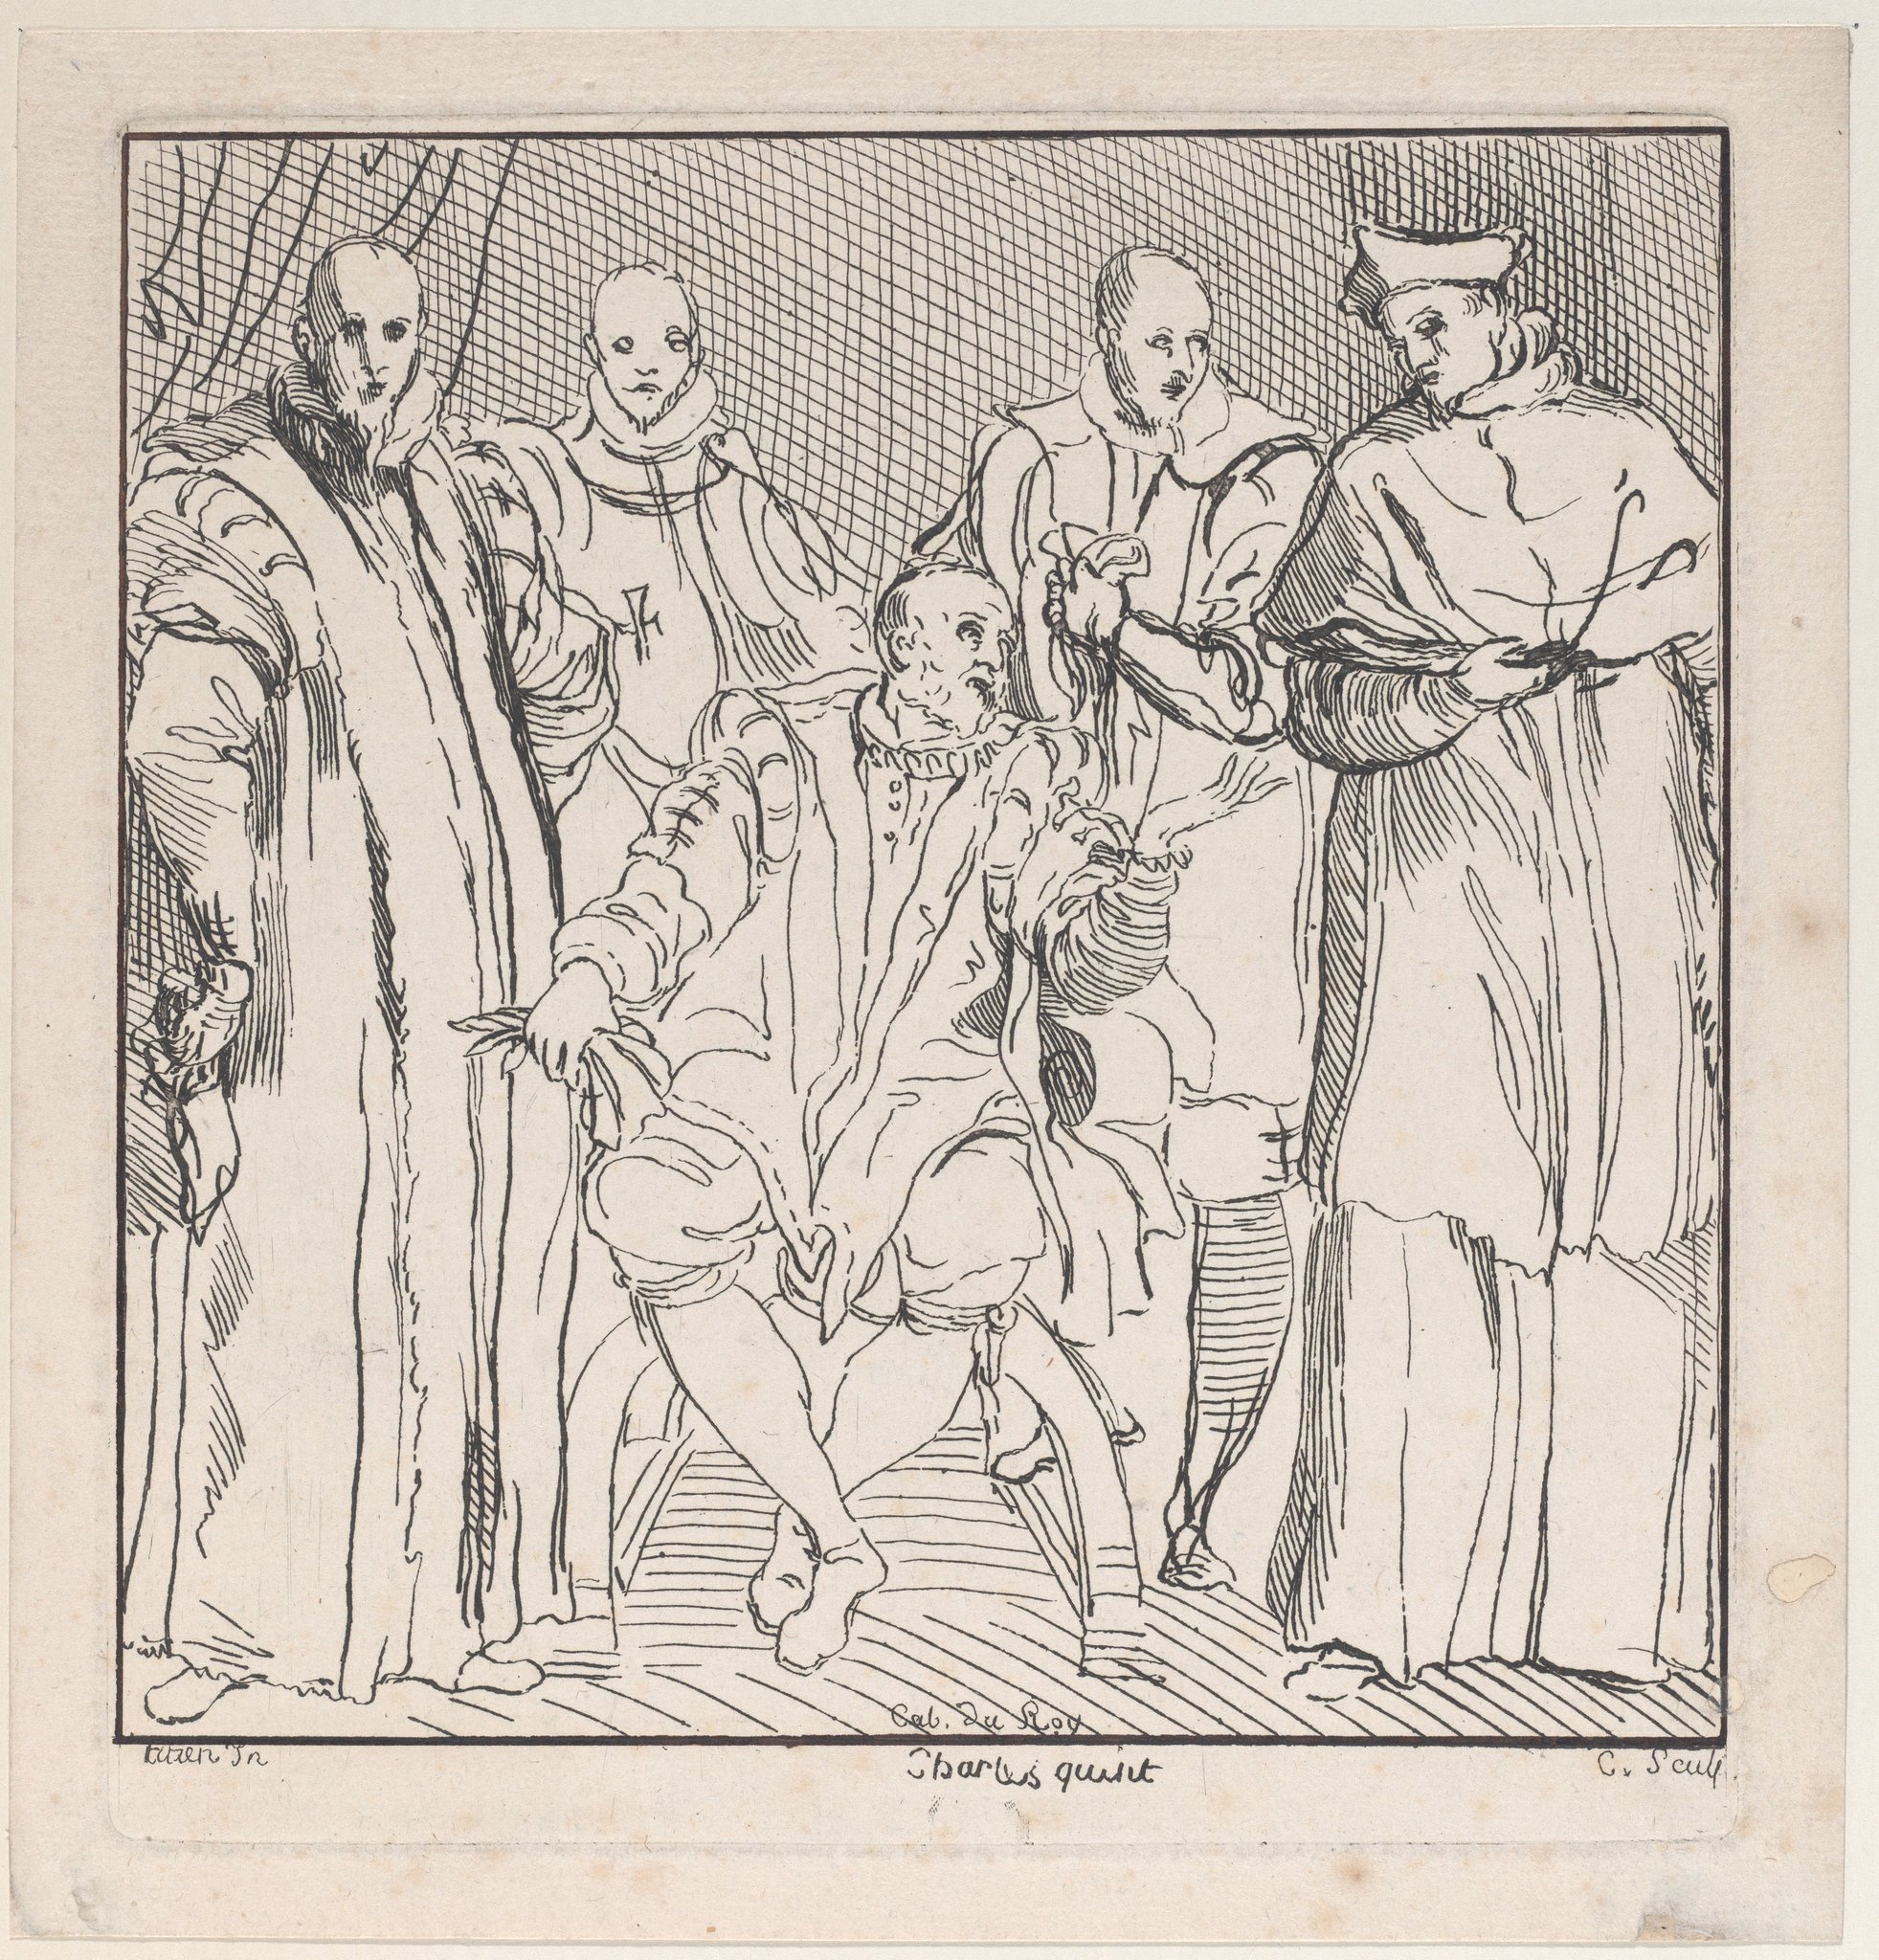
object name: print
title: Charles V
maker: anne claude philippe de tubières, comte de caylus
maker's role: artist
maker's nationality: french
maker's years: 1692-1765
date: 1701-1800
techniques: etching